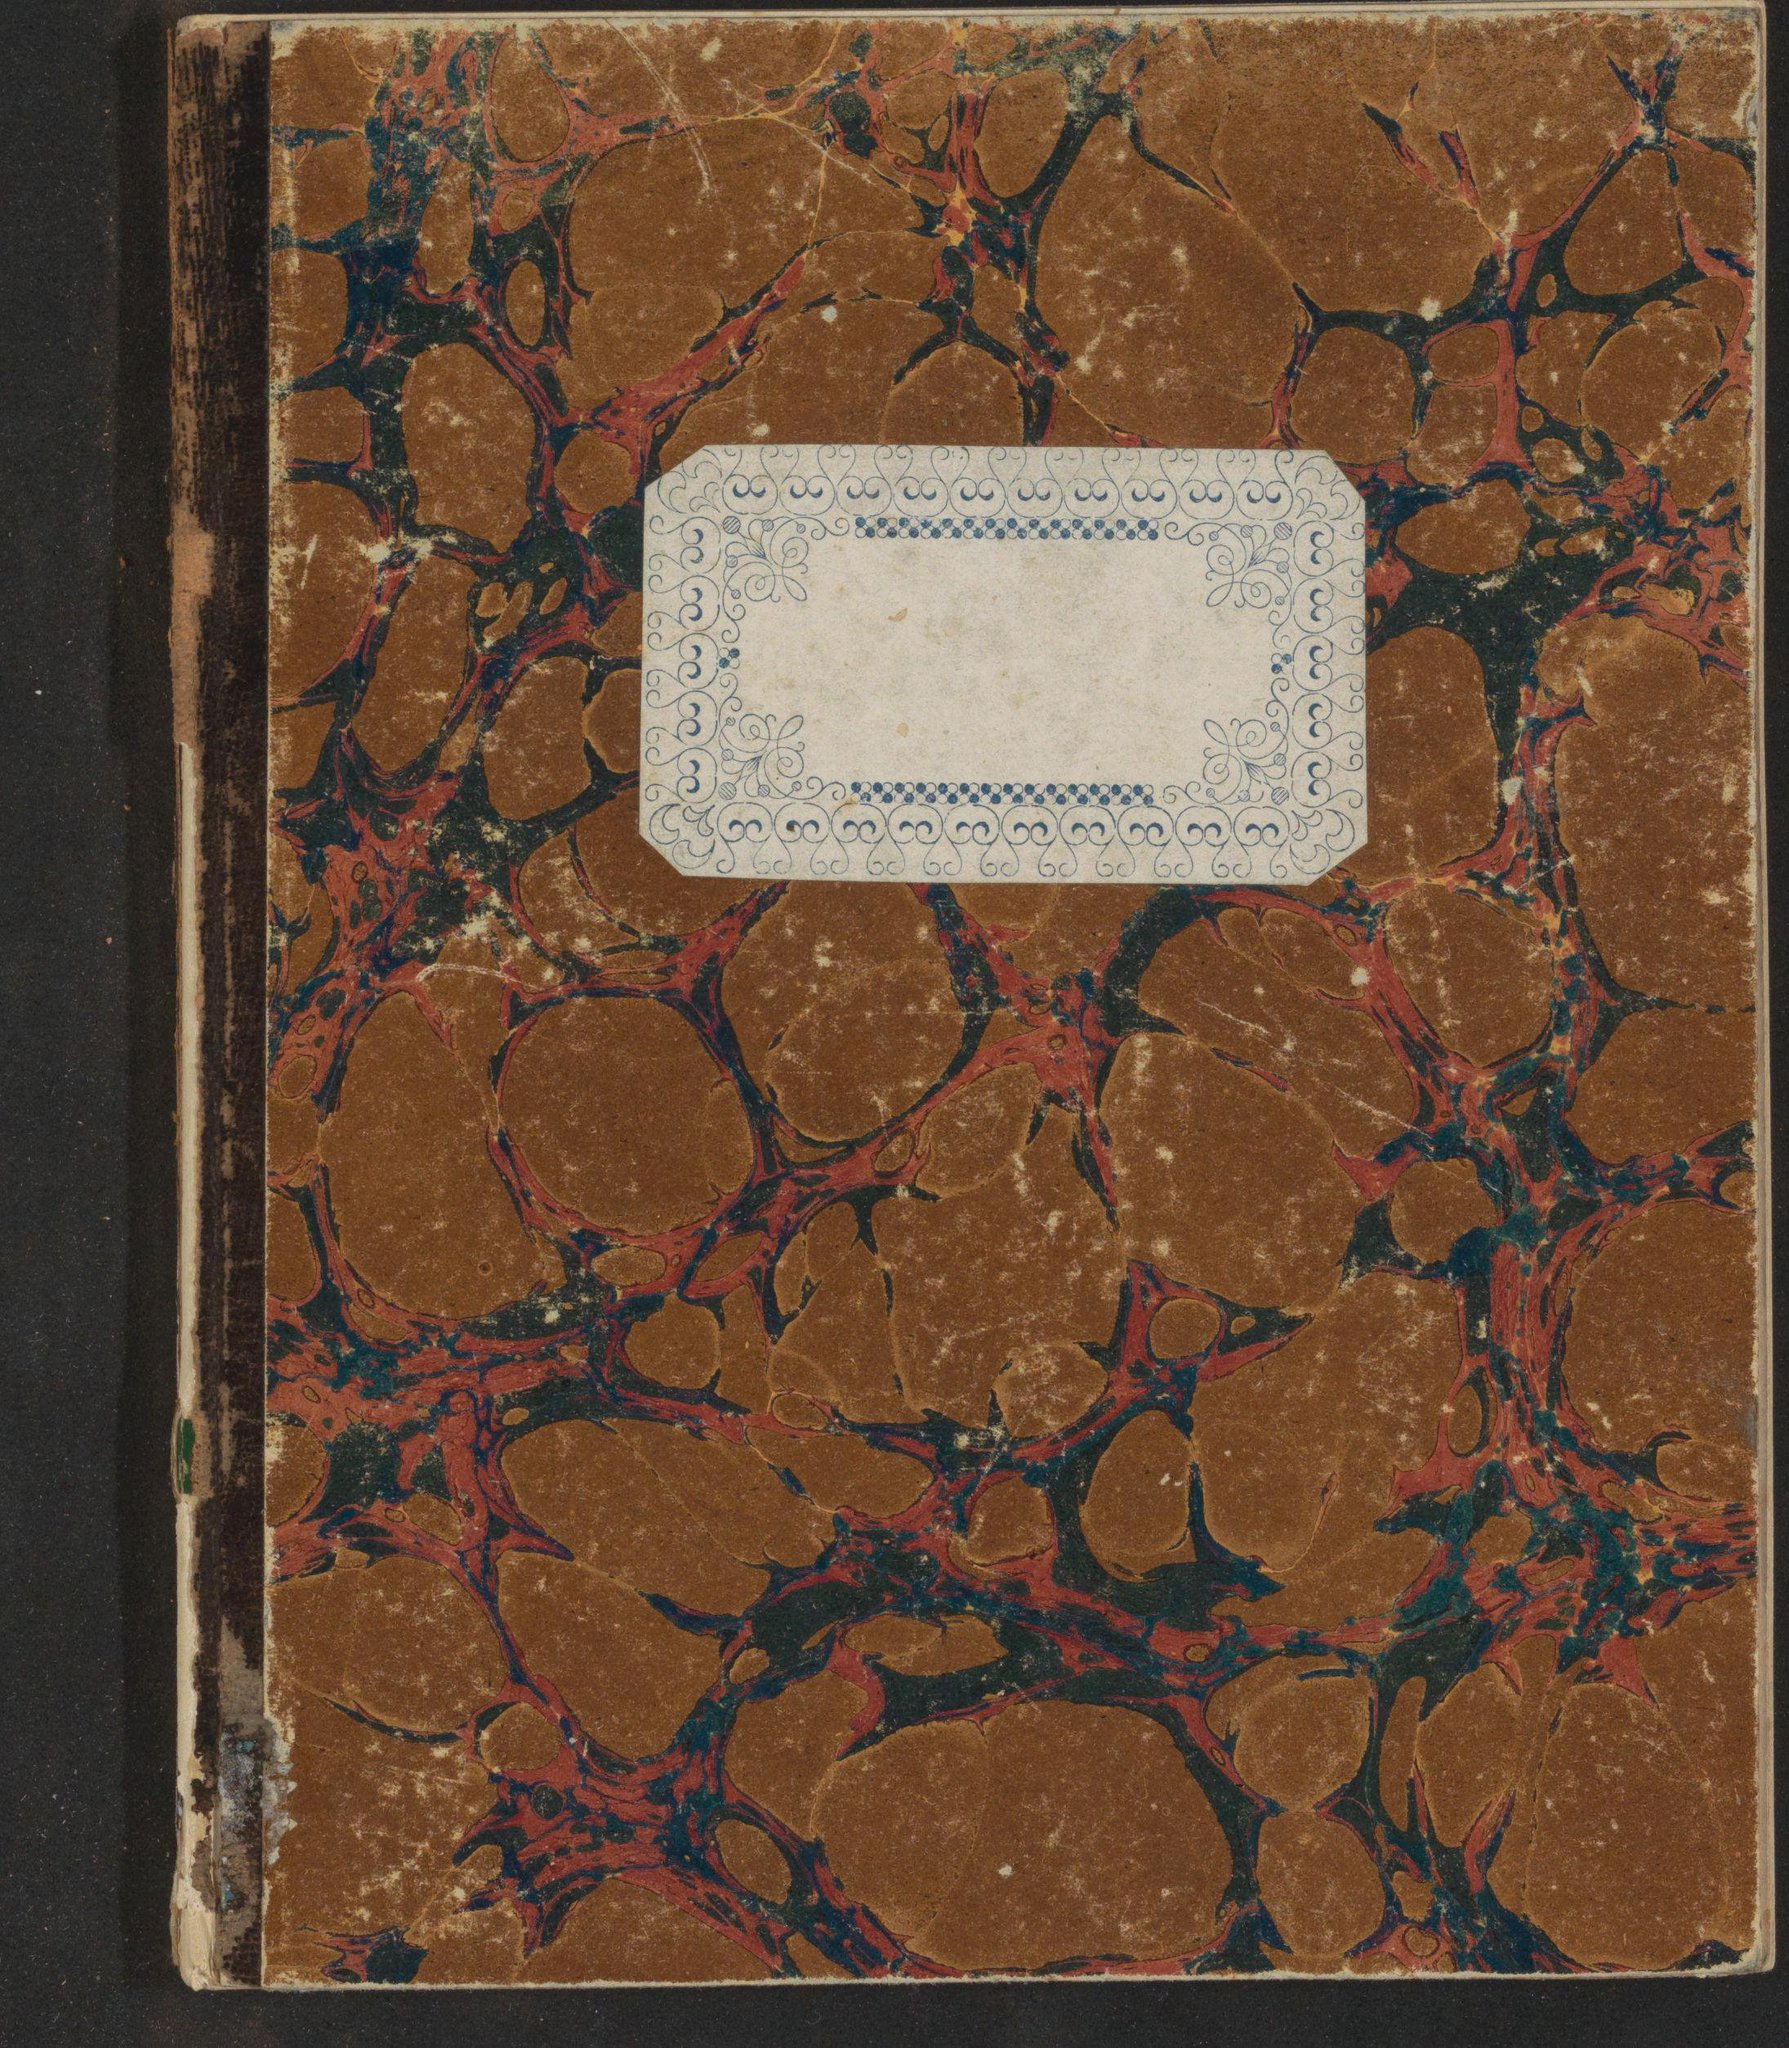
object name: sketchbook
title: Schetsboek met 44 bladen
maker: gaspard louis françois van kinschot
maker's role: print maker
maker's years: 1811-1861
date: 1821-1861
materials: cardboard, ink, linen, paper, pencil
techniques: pen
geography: gouda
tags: piece of sculpture, reproduction of a piece of sculpture, other memorial structures, armorial bearing, heraldry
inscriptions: annotation: ‘Hoort bij B987/ Grafschriften in St-Jans-Kerk/ te Gouda’, collector's mark: Lugt 2166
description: Schetsboek bestaande uit 44 bladen met grafschriften, wapenschilden en monumenten in de Grote of St. Jans Kerk te Gouda. Bij het schetsboek wordt een losse tekening met beschrijving bewaard van de epitaaf van Joseph van Arnhem (1547-1616) in de kerk te Velp, gedateerd november 1855.